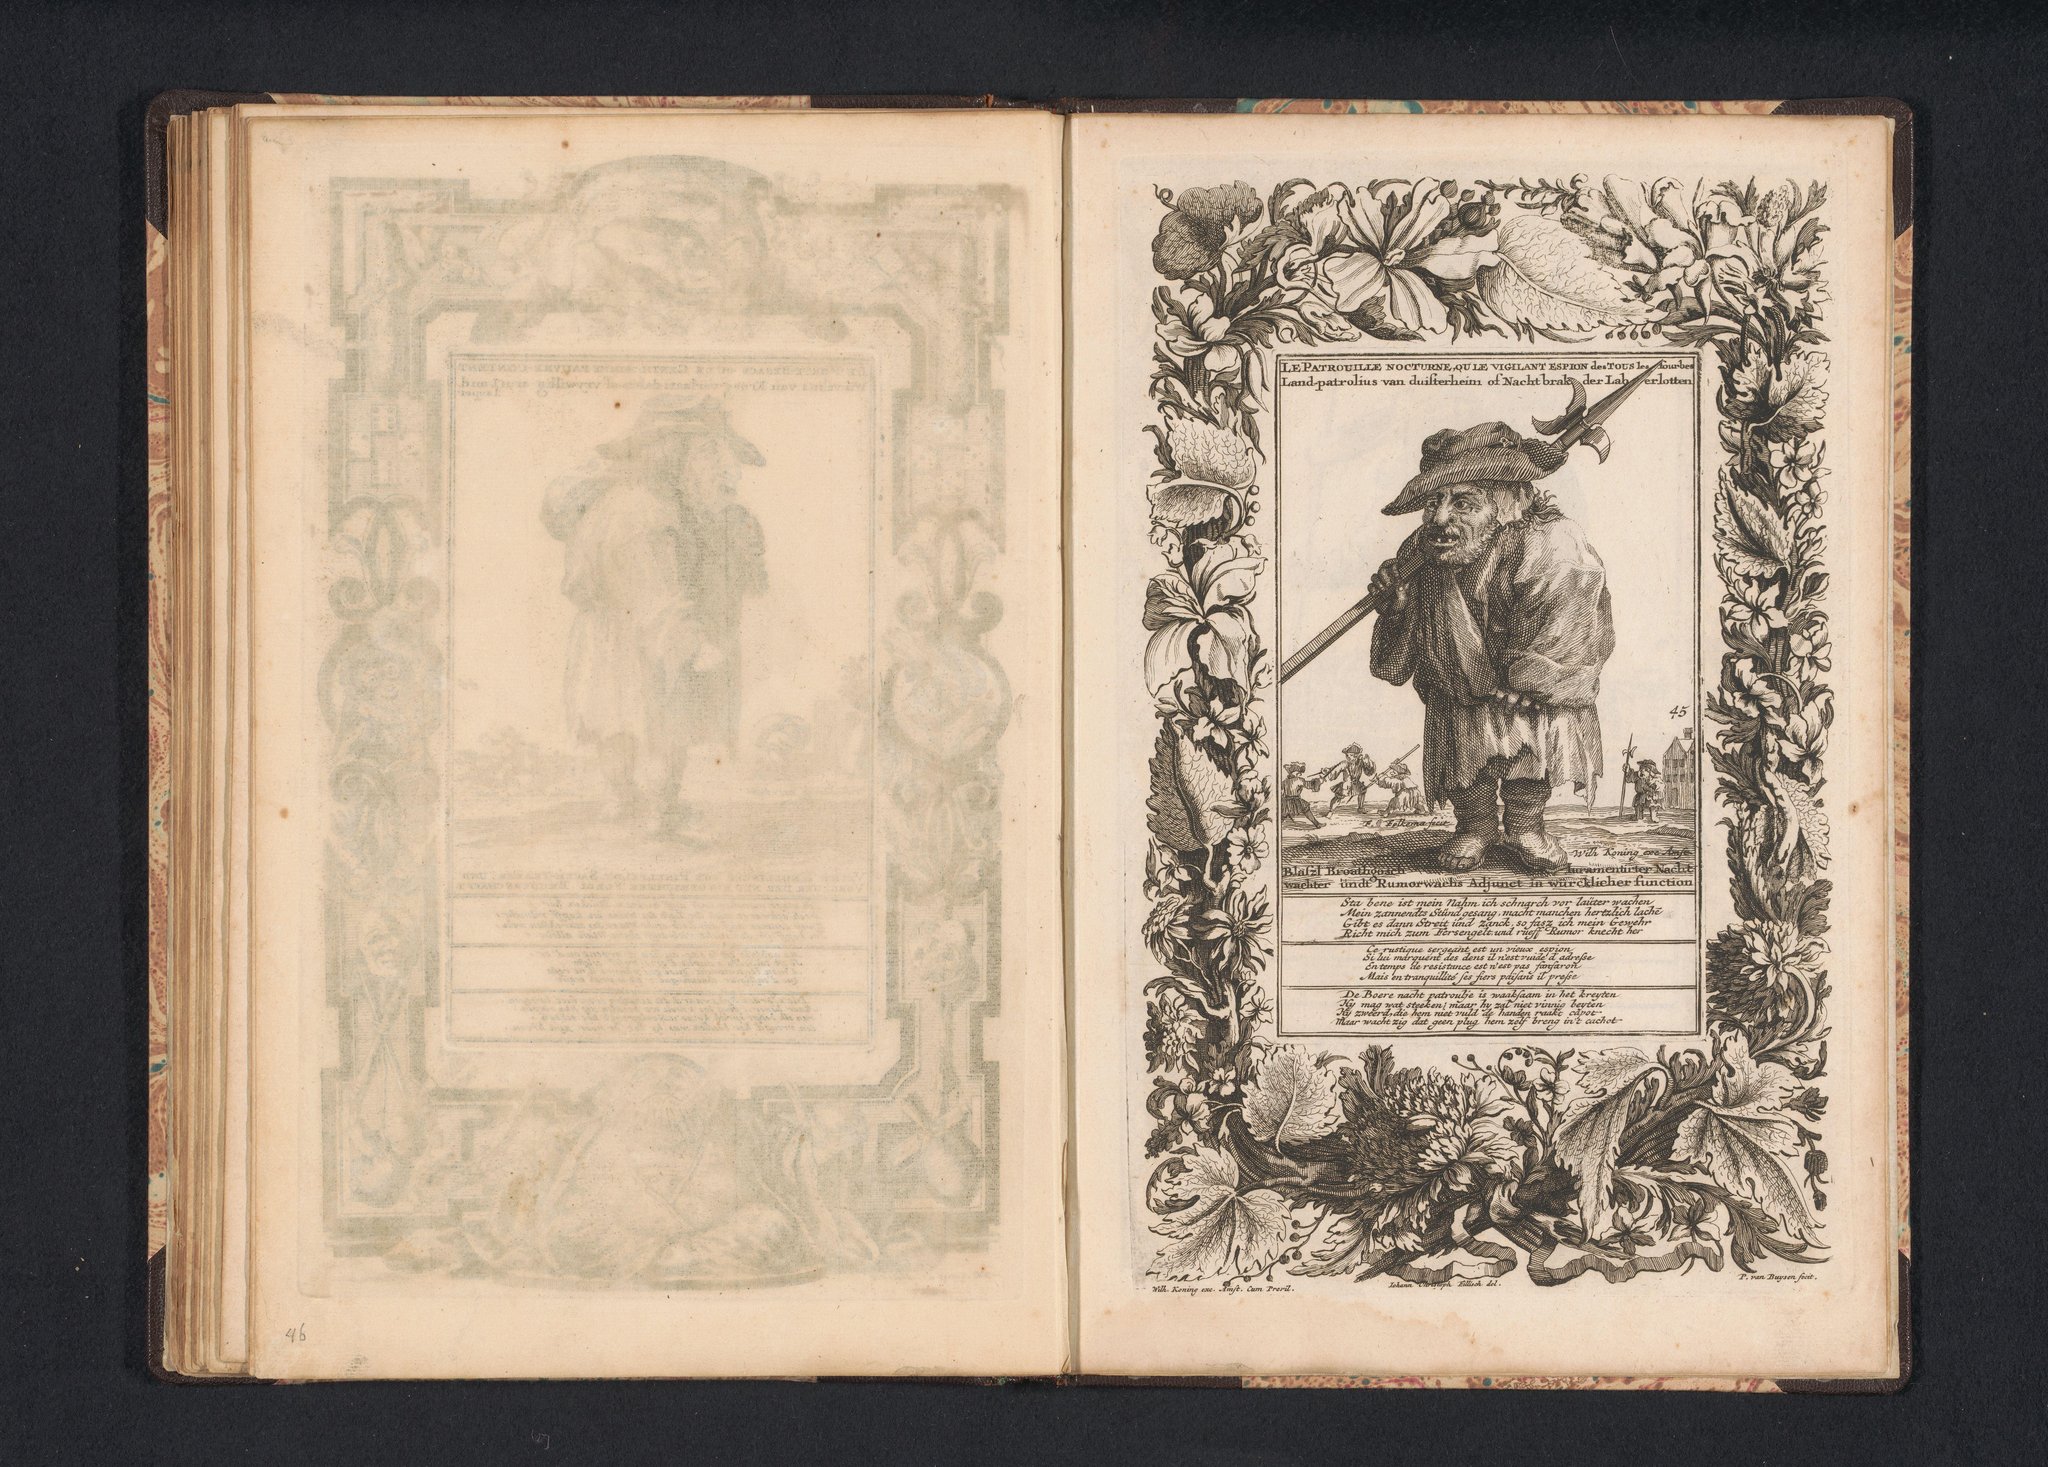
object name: caricature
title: De kleine mens Land-patrolius van duisterheim, 1716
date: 1716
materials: paper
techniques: etching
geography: northern netherlands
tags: night patrol, caricatures (human types), little people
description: De kleine mens Land-patrolius van duisterheim als nachtwaker. In het onderschrift verzen in het Duits, Frans en Nederlands. Afdruk binnen een decoratieve omlijsting gedrukt van een aparte plaat met bloemen. Genummerd rechts midden: 45. Onderdeel van de Nederlandse gebonden uitgave uit 1716 van een serie karikaturen van kleine mensen, bekend als Het Dwergentooneel, gekopieerd naar een ouder Duits voorbeeld.